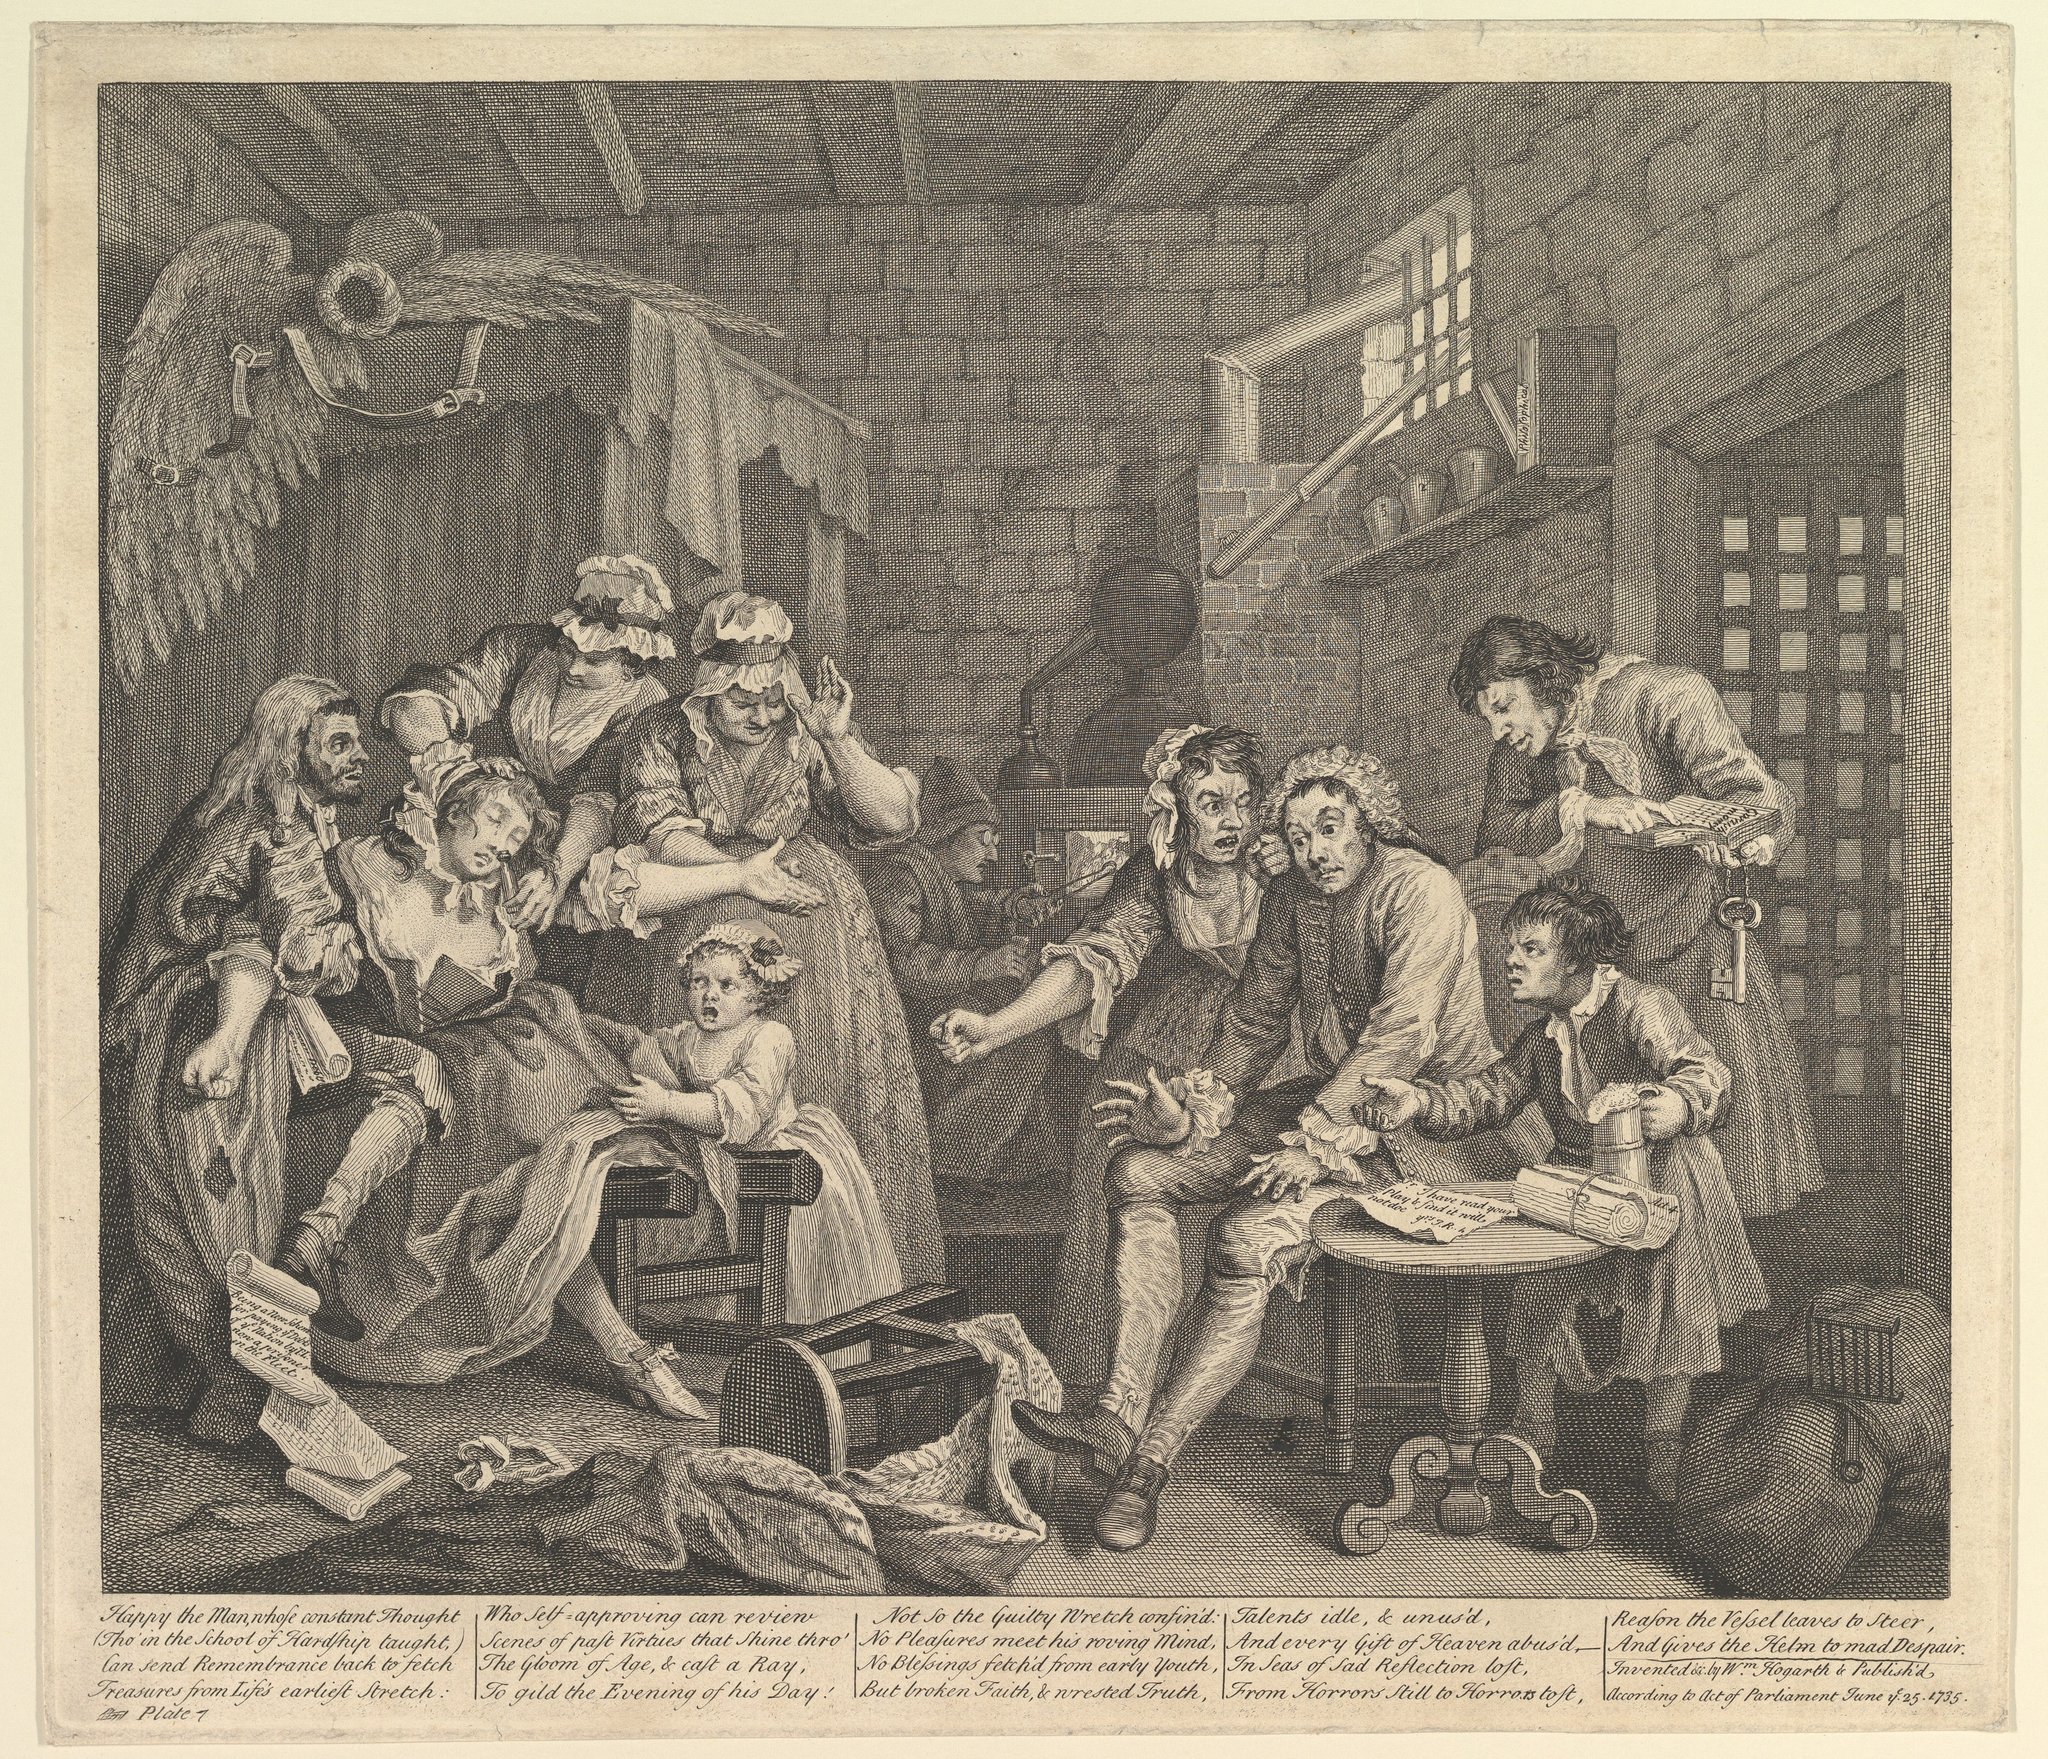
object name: print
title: A Rake's Progress, Plate 7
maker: william hogarth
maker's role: artist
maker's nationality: british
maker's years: 1697-1764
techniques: engraving, etching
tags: boys,girls,men,women